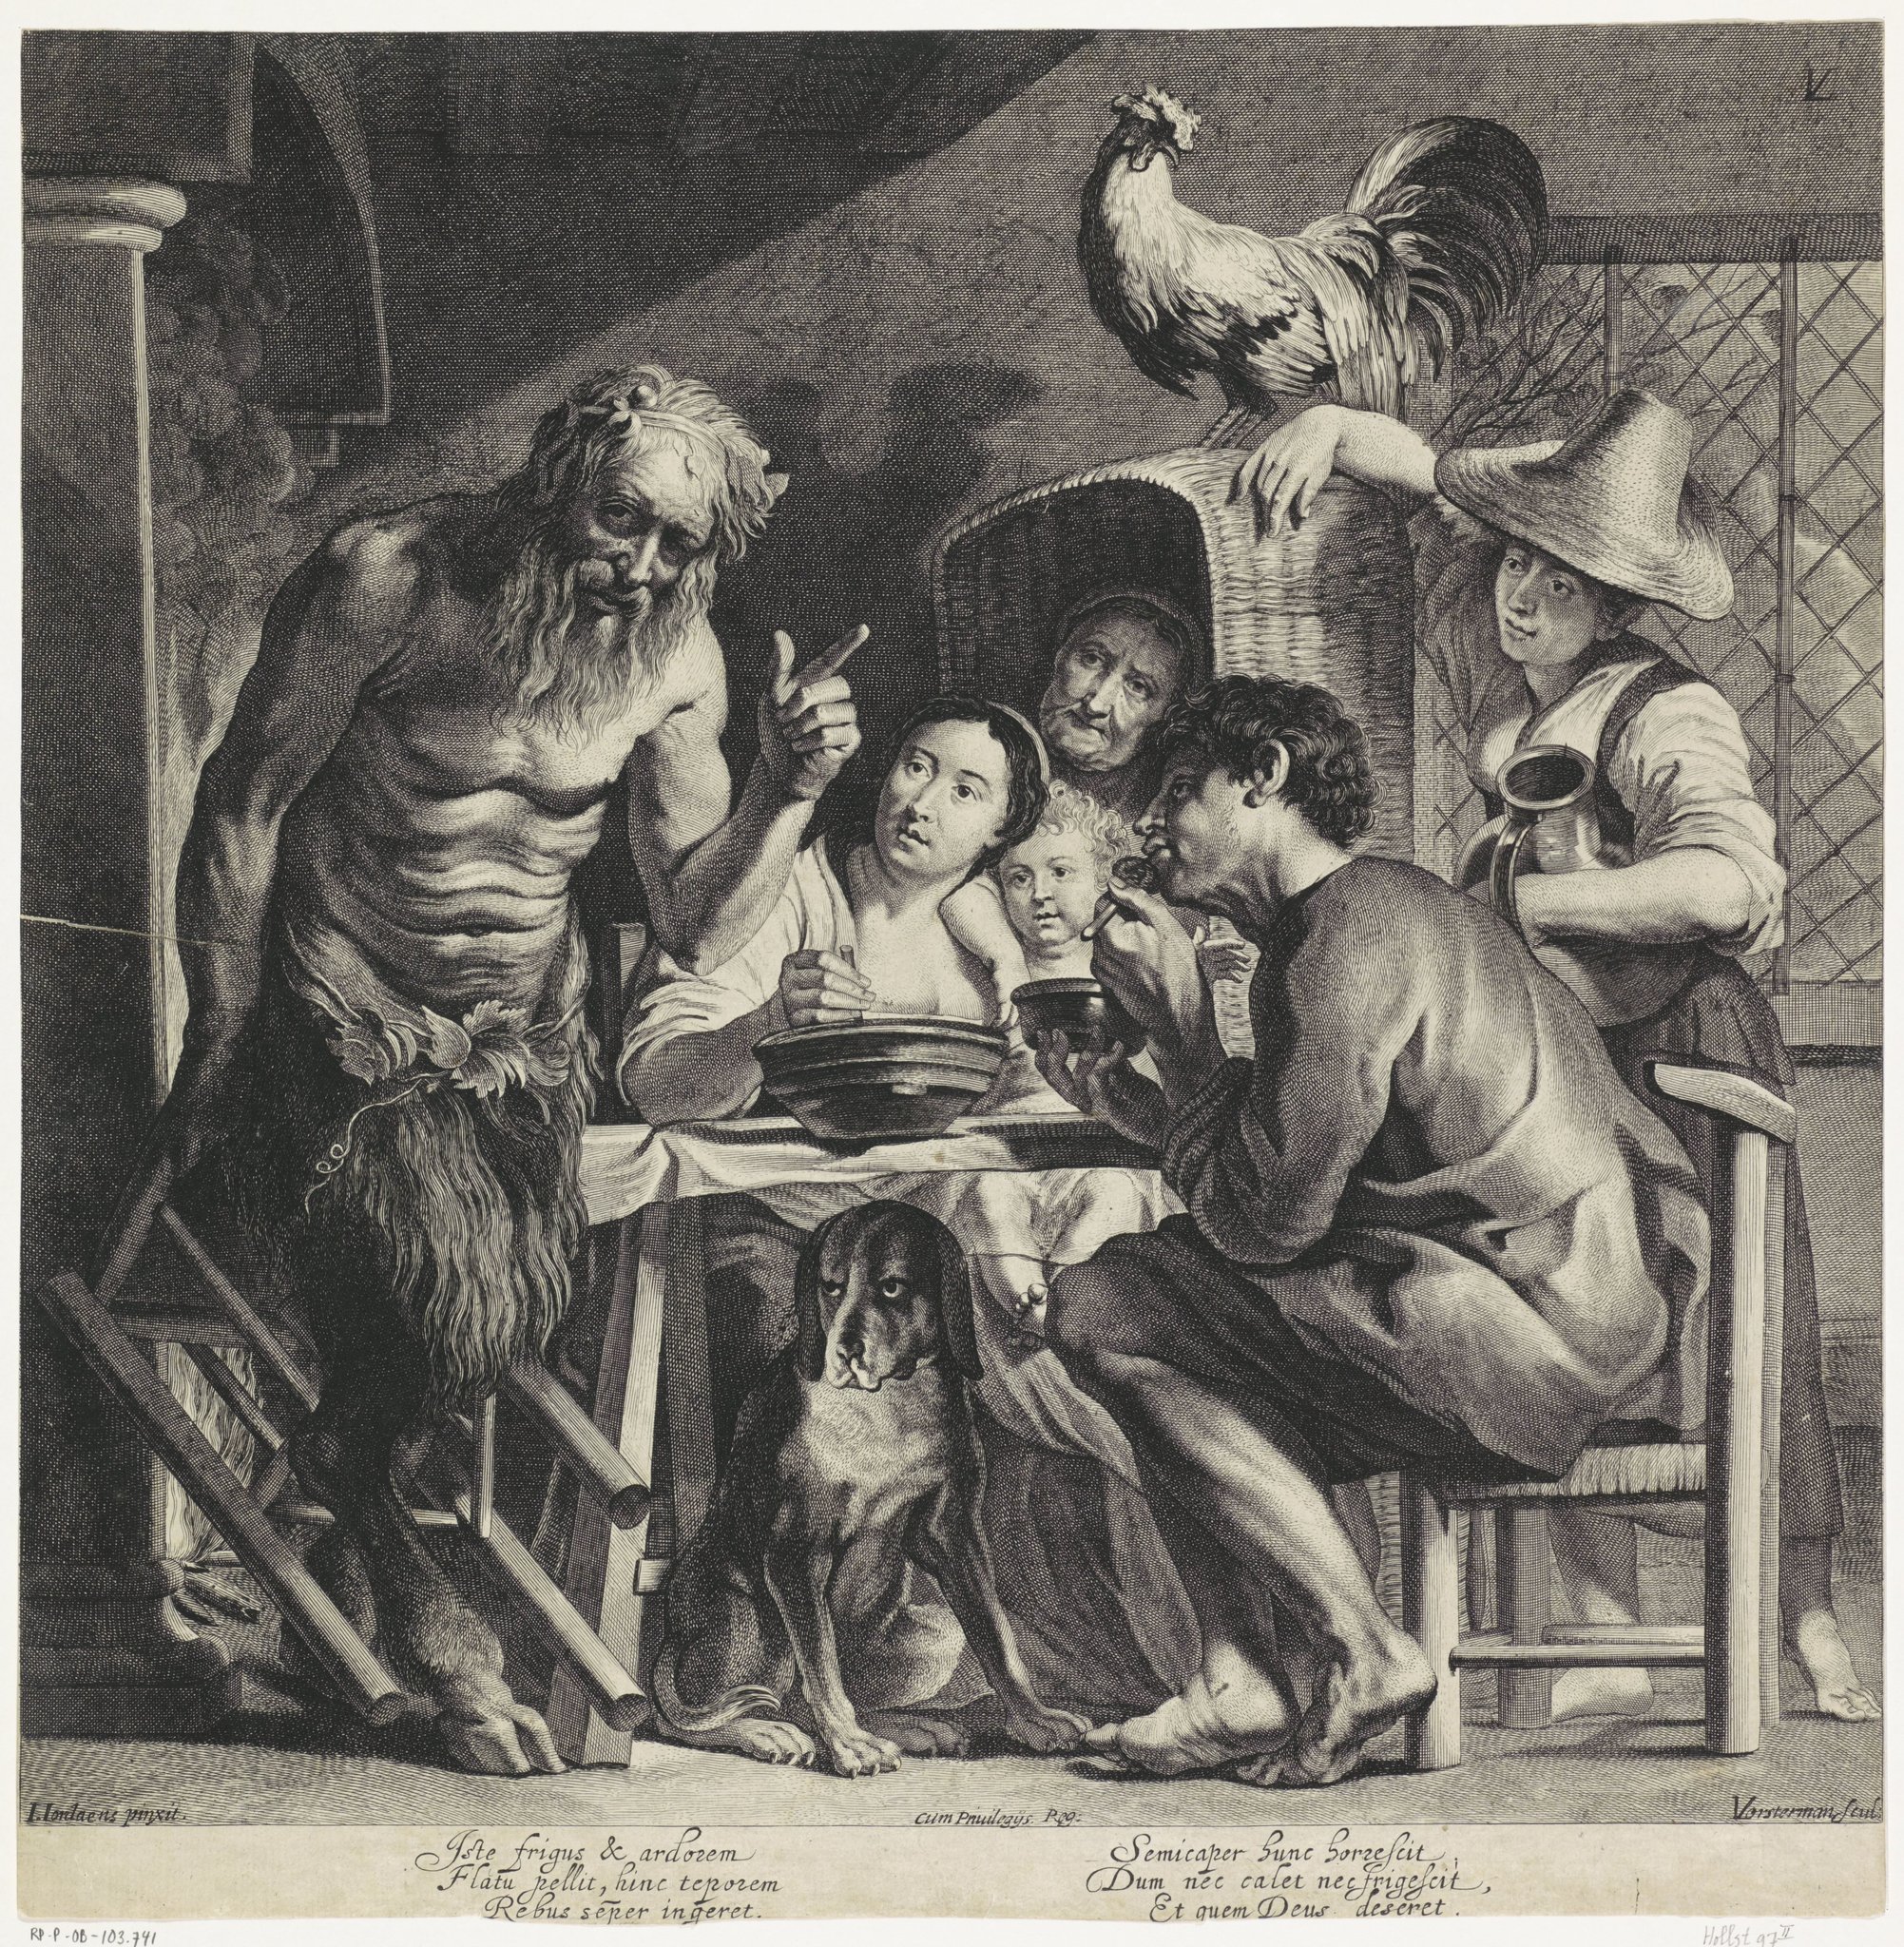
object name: print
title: Sater en de boer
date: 1619-1675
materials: paper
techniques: engraving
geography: antwerp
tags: the satyr and the peasants; according to aesop: the satyrs and the peasant (meal, blowing to cool food, etc.)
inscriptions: collector's mark: Lugt 2228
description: Uitbeelding van een verhaal van de Griekse fabelschrijver Aesopus: een sater, op bezoek bij een boerenfamilie, ziet tot zijn verbazing dat de boer zowel warm als koud kan blazen. Hij warmt zijn koude handen met zijn adem, maar blaast daarna in de hete soep om hem af te koelen. De sater beschouwt dit als tovenarij en wil het huis verlaten.